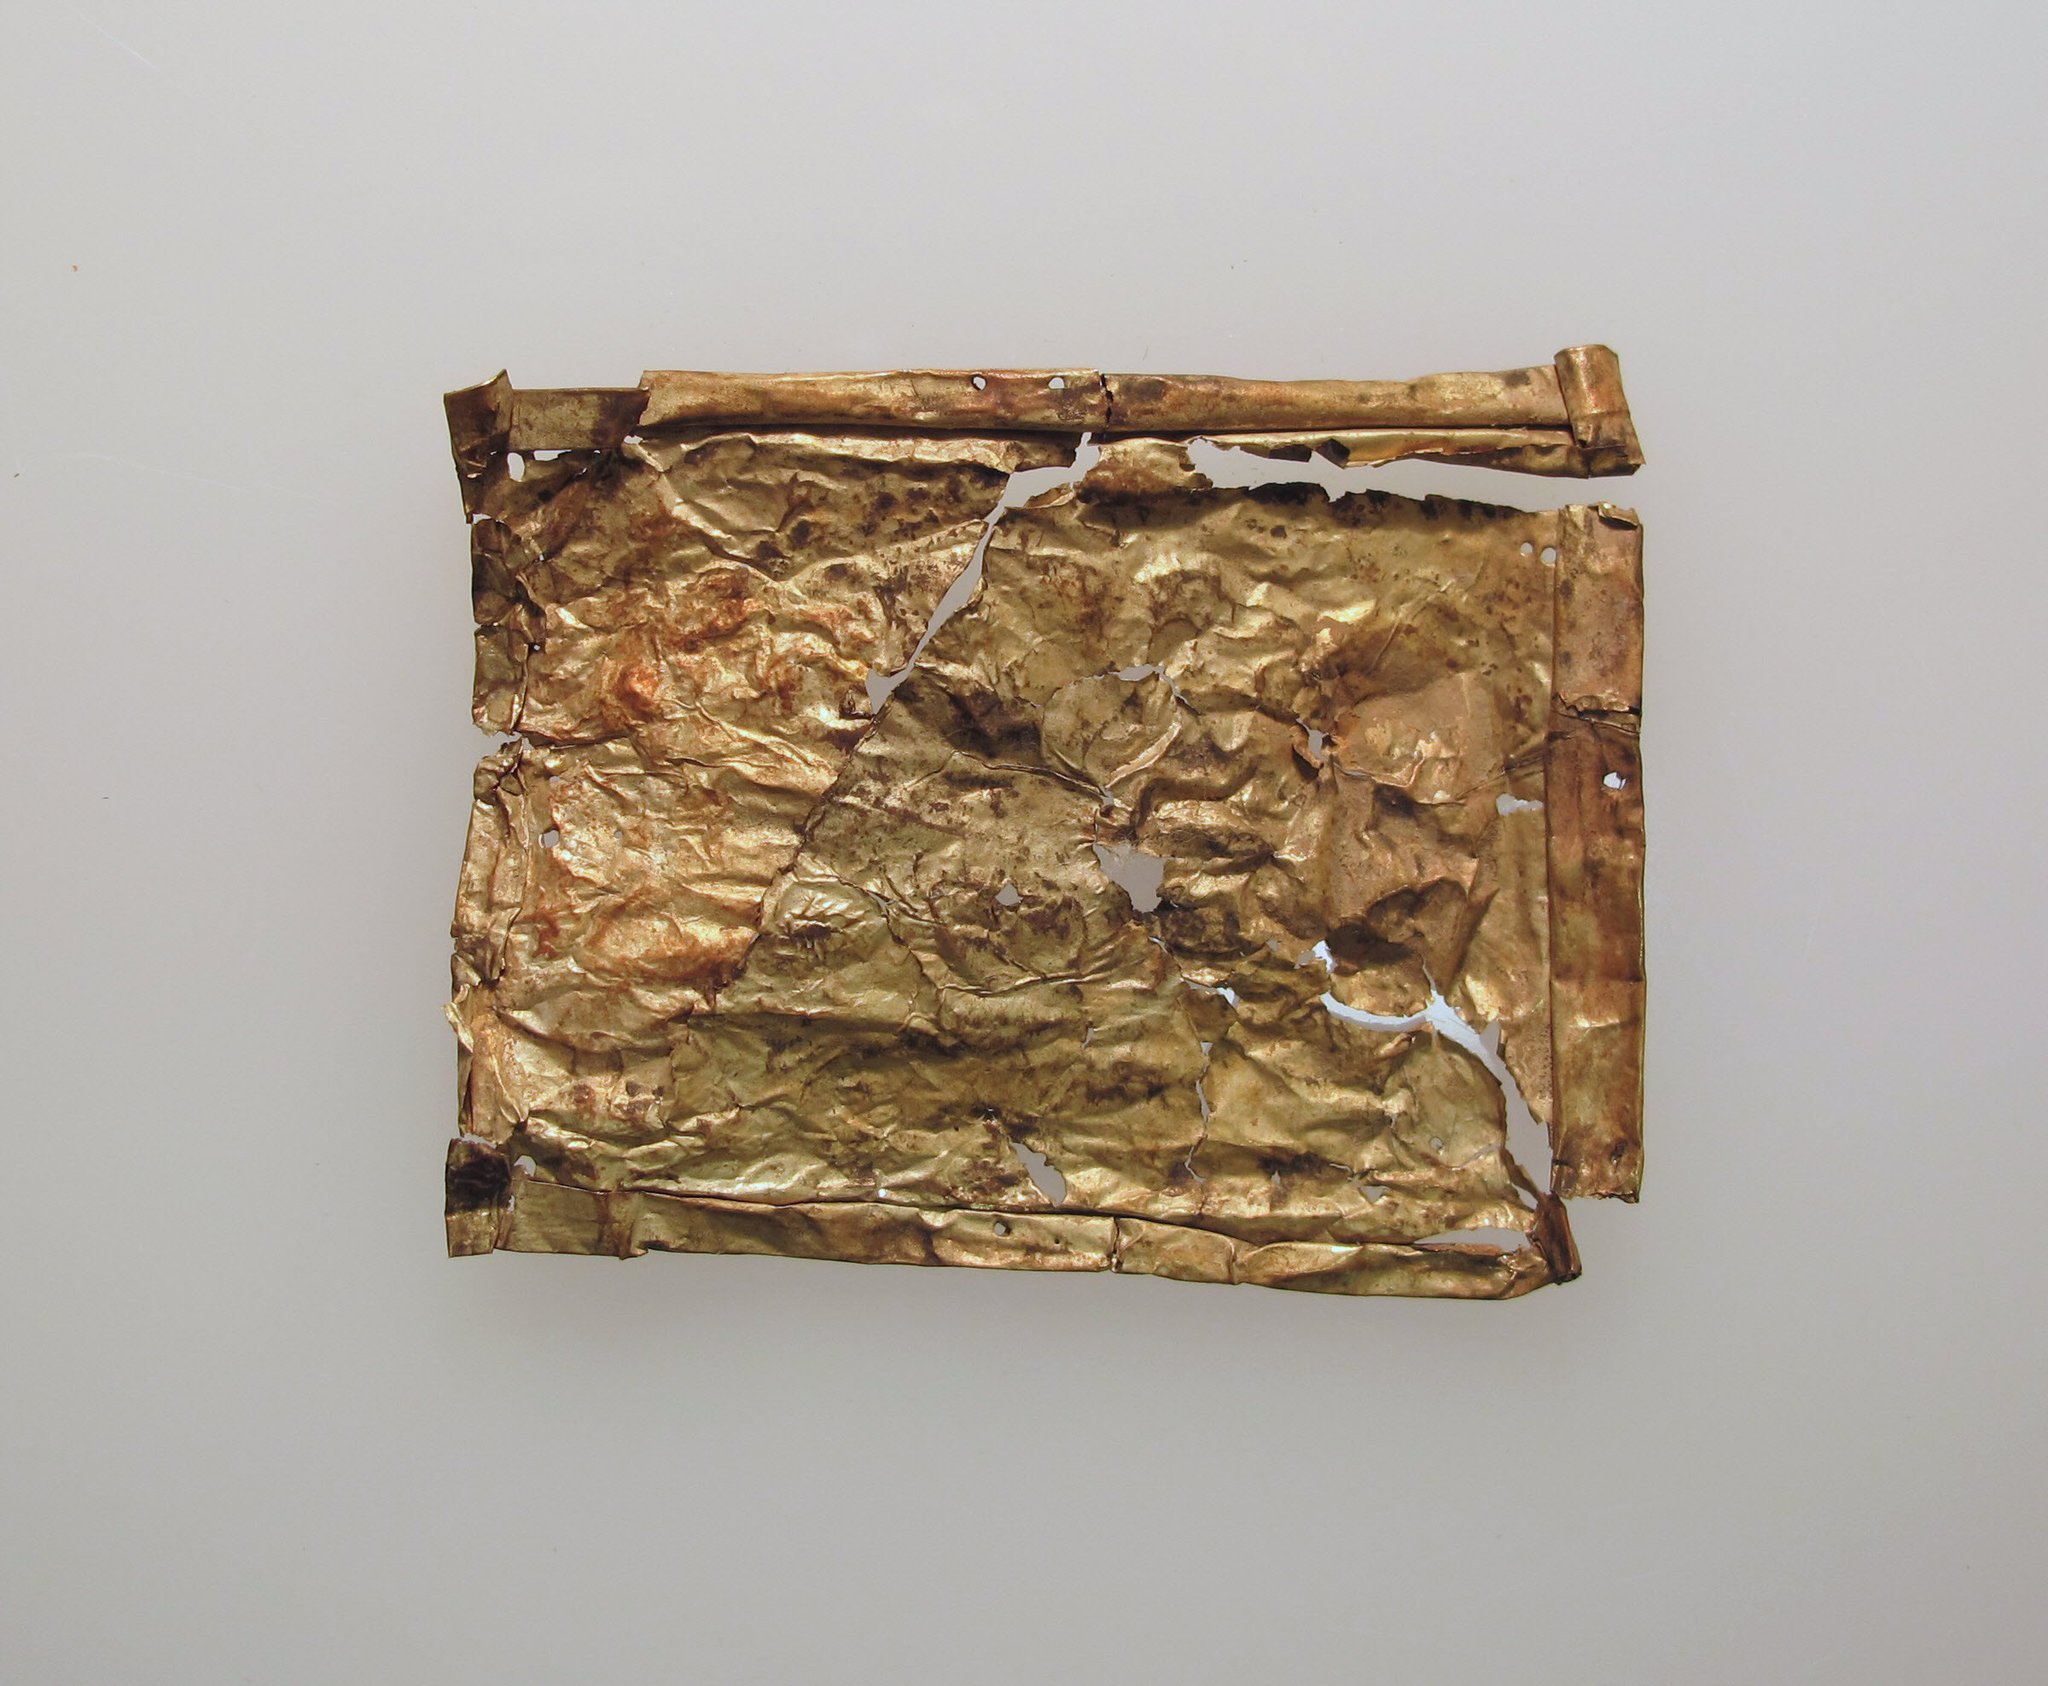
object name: plaque, thin gold leaf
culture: cypriot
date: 3900 BCE-100 CE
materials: gold